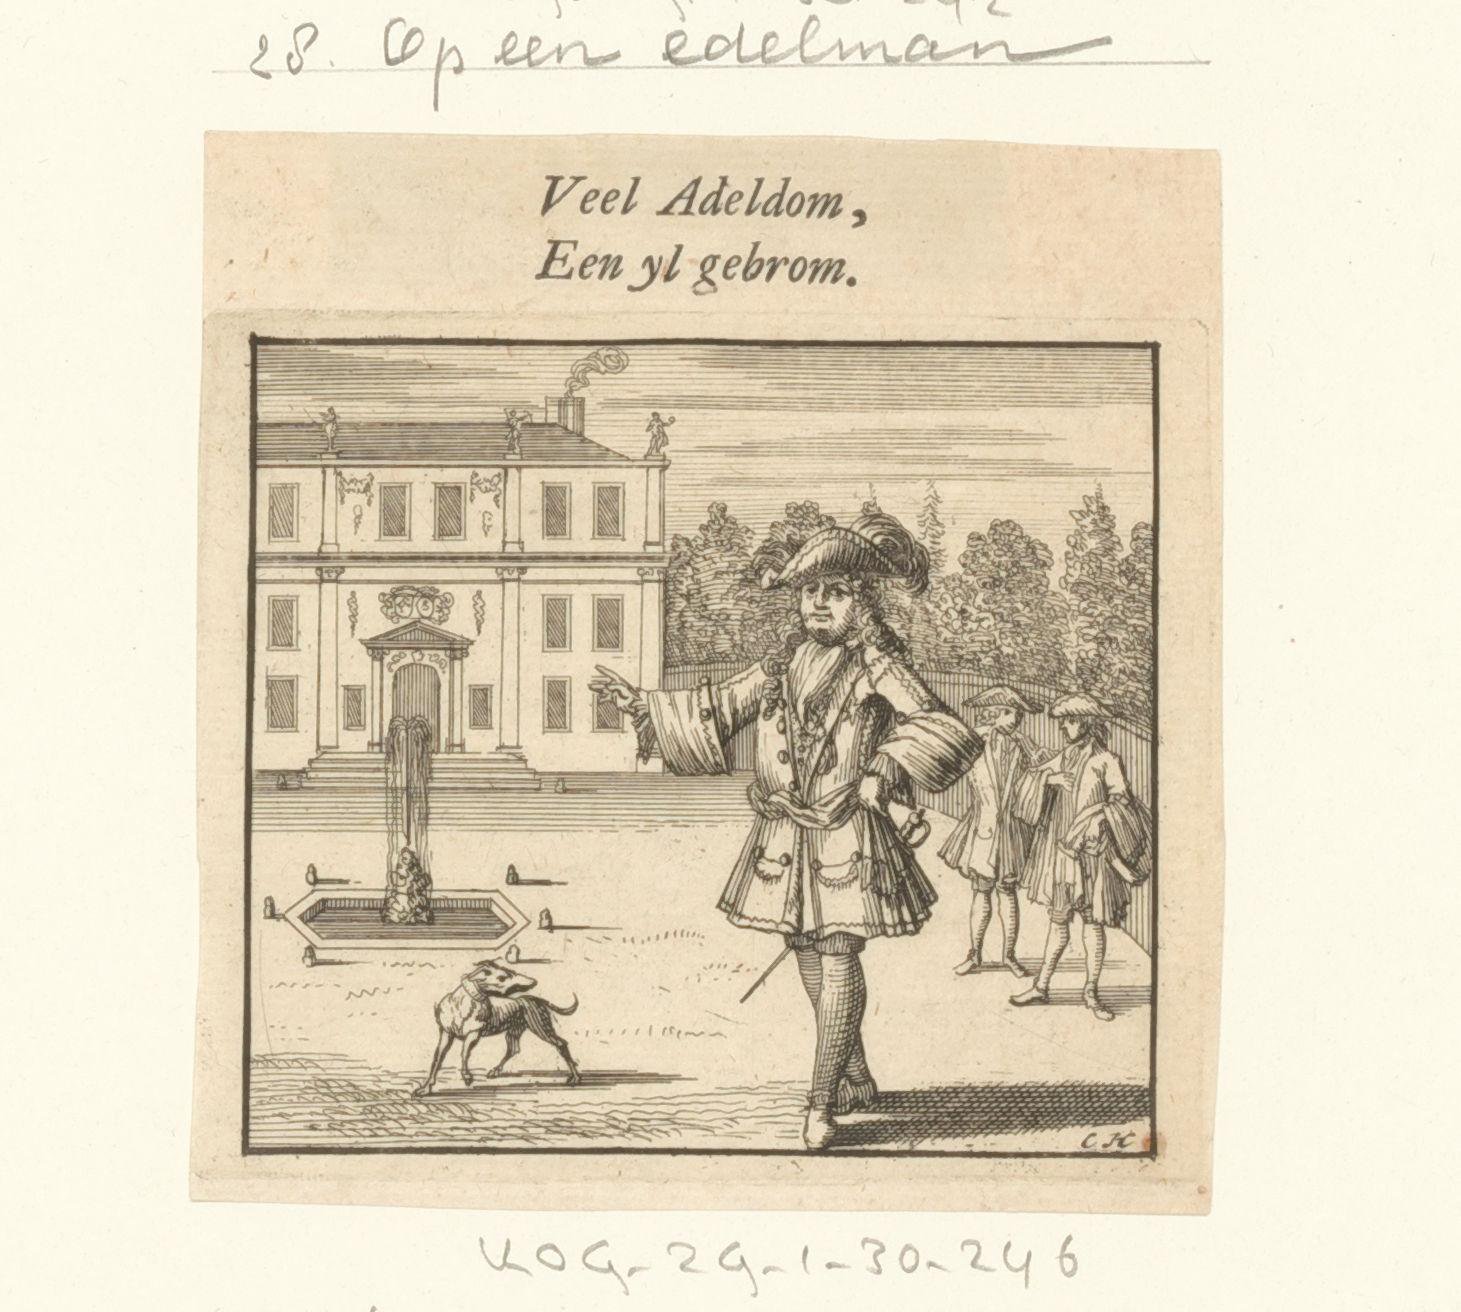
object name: print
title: Veel Adeldom, Een yl gebrom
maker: cornelis huyberts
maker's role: print maker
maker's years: 1669-1709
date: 1725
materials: paper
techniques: etching, letterpress printing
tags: nobility and patriciate; chivalry, knighthood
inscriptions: collector's mark: Lugt 1641, stamp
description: Prent uit: Graauwhart, Hendrik. Voorbeeldelyke zeede-lessen, genoomen uyt den eersten toestand des werelds (...). Amsterdam: Johannes Ratelband, 1725. Prent ook gebruikt voor eerdere en (1709) latere uitgave (1756, 1761 en 1764).